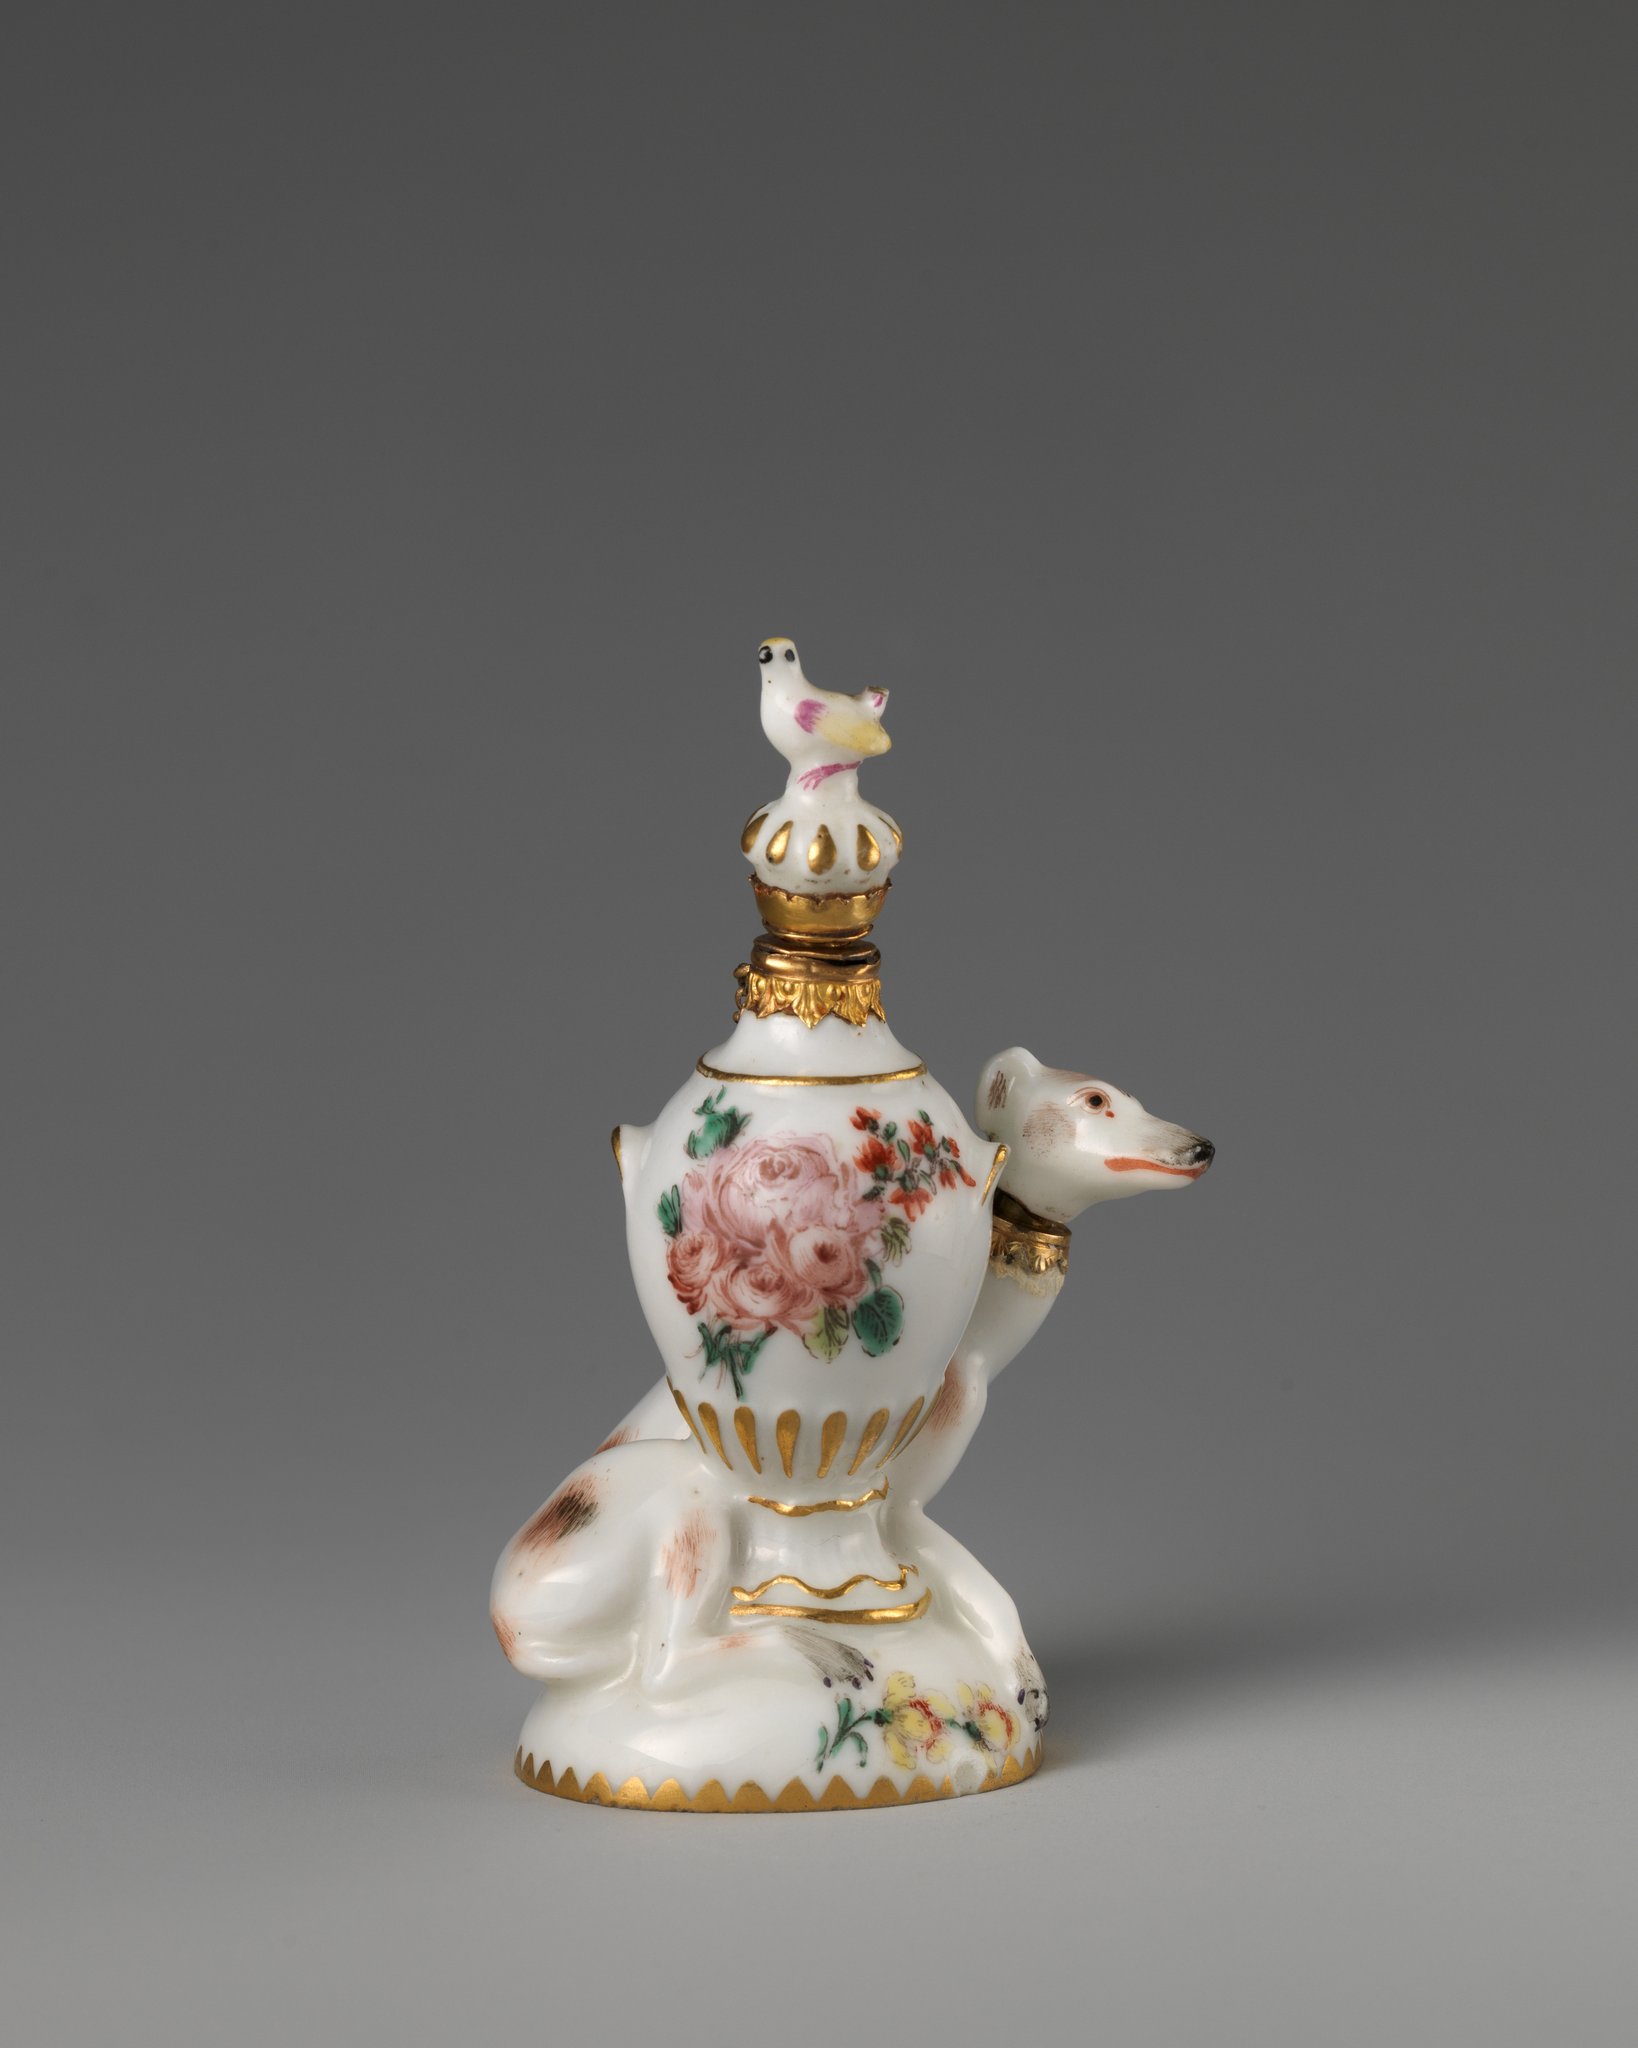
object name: toy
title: Greyhound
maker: chelsea porcelain manufactory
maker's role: factory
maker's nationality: british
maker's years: 1744-1784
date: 1755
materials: soft paste porcelain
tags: birds,dogs,roses,leaves